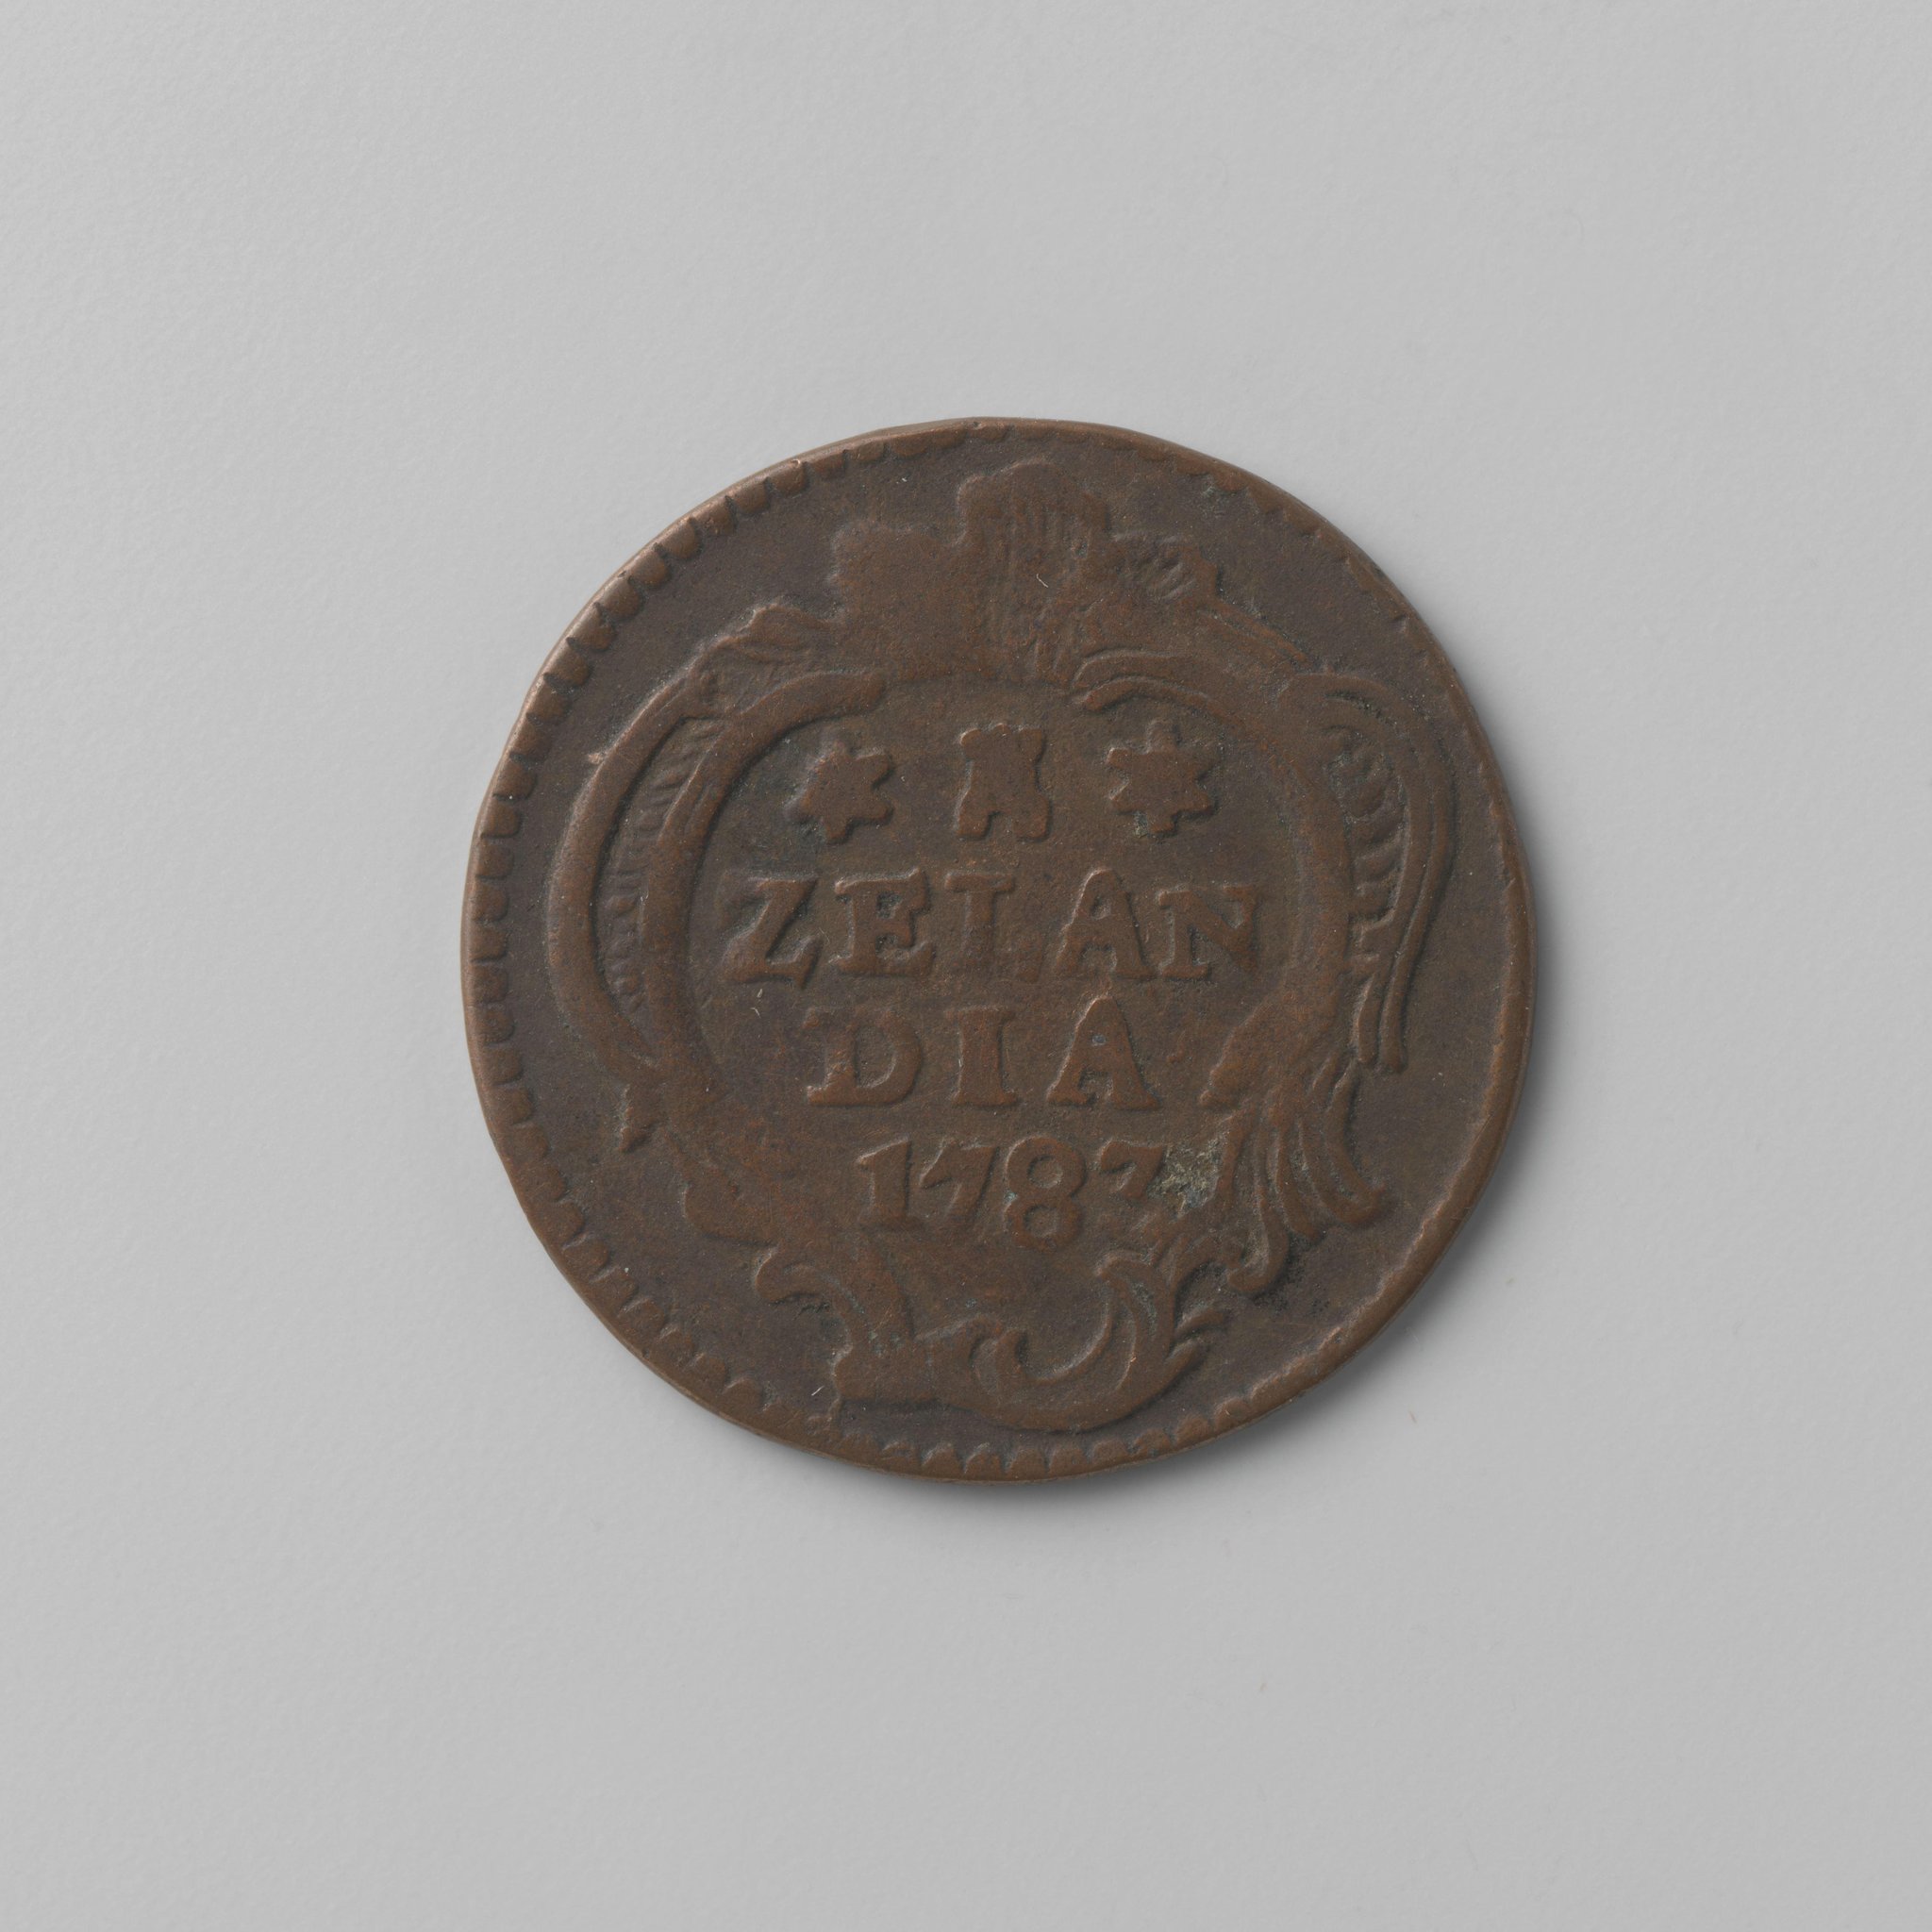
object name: coin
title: Zeeland, duit, 1783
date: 1783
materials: copper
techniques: striking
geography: middelburg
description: Koperen munt. Voorzijde: in rococo-lijst gekroond ovaal wapenschild van Zeeland. Keerzijde: in een rococo-versiering opschrift in drie regels, waarboven muntteken burcht tussen twee sterren en waaronder jaartal.